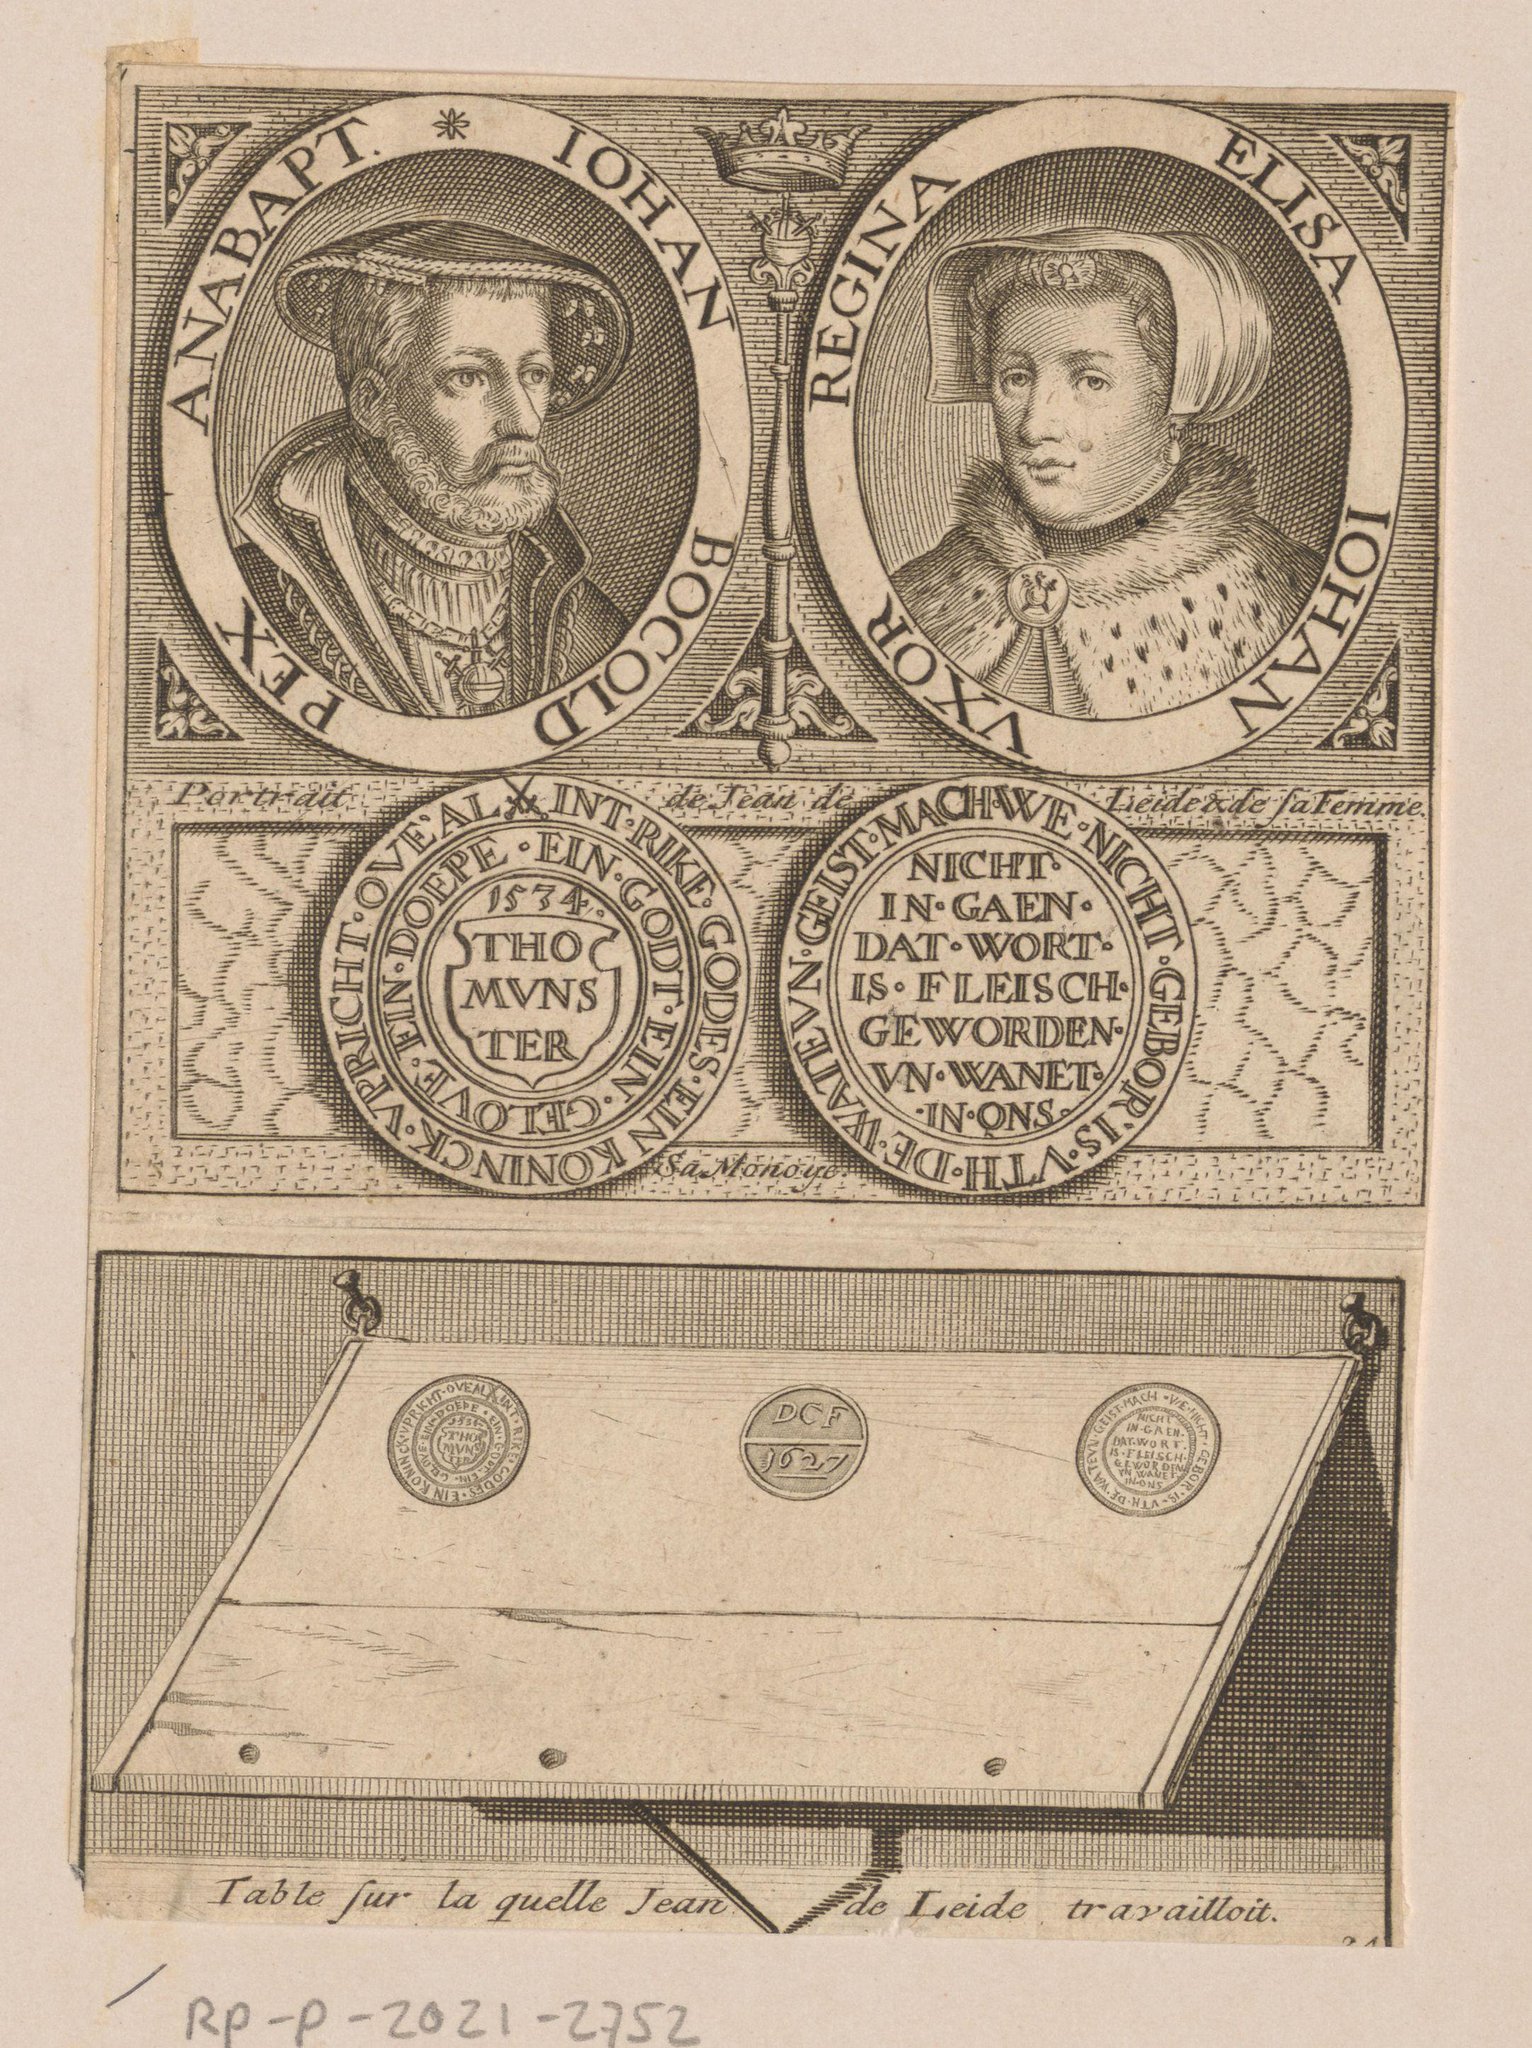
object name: print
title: Dubbelportret van Jan van Leiden en Elisabeth Wandscherer en werktafel van Van Leiden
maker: Anonymous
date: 1712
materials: paper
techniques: engraving, etching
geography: northern netherlands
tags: leiden, writing-table, writing-desk, crown (symbol of sovereignty), historical persons - bb - woman, sceptre, staff (symbol of sovereignty), ornament ~ medallion, historical persons, coin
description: Prent waarschijnlijk uit: Les Delices de Leide (...). Leiden: Pieter van der Aa, 1712. De prent is eerder gebruikt in 'Beschrijvinge der Stadt Leyden (...)', uit 1614 en 1641.